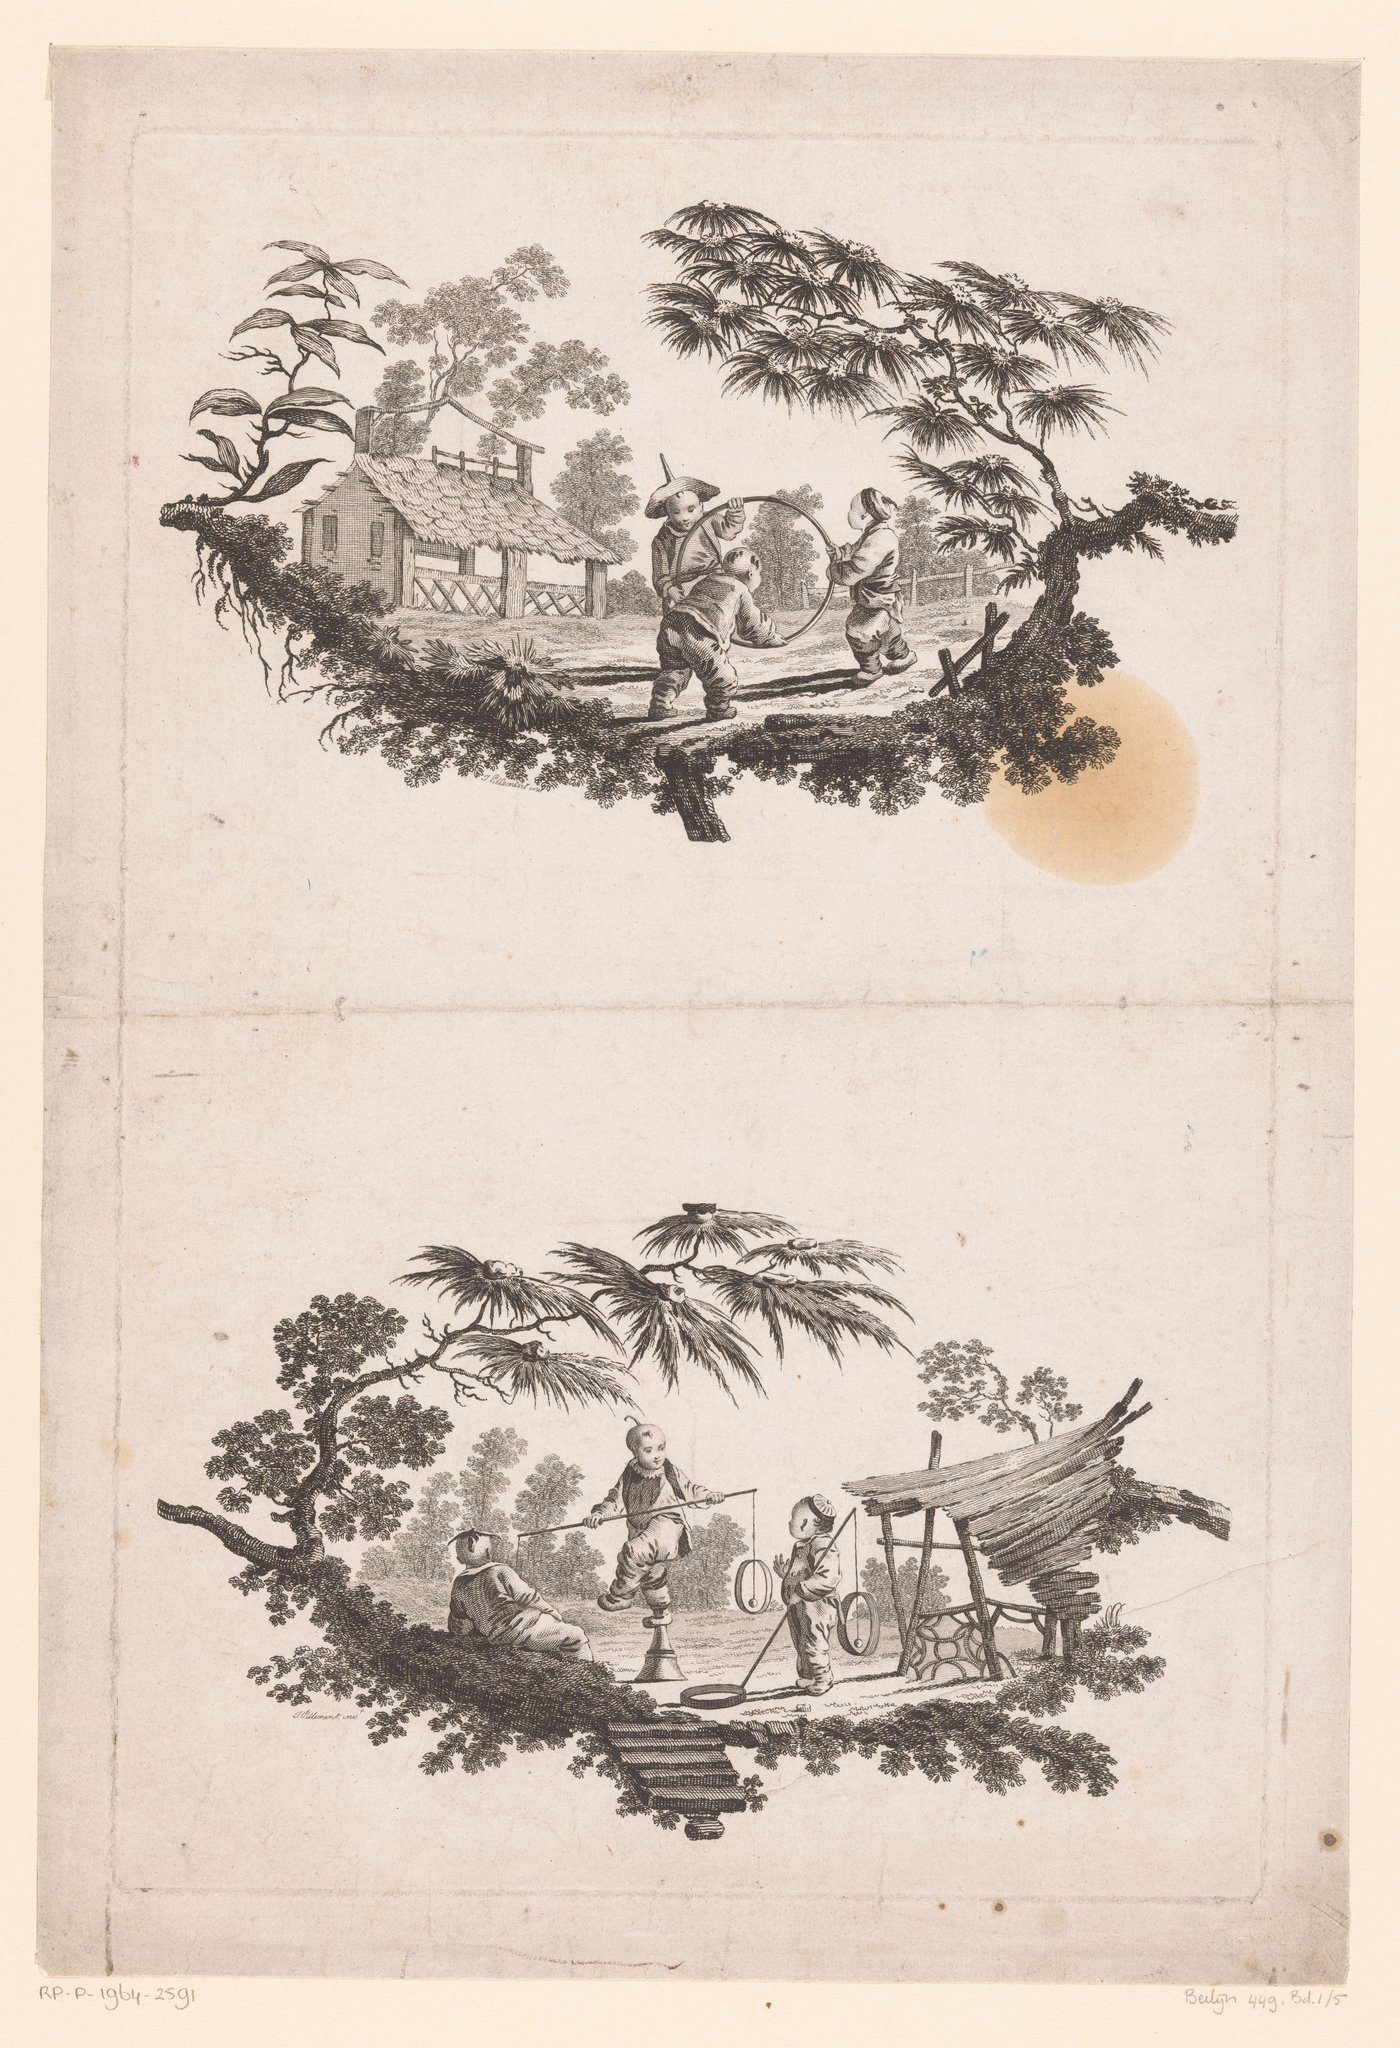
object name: print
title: Kinderen met hoepel en balancerend met stok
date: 1759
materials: paper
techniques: etching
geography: london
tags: children's games and plays, (bowling a) hoop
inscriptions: collector's mark: Lugt 2228, collector's mark: Lugt 2760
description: Boven: Drie Chinese kinderen spelen met een hoepel. Onder: Een Chinees kind balanceert op een pion met een stok in zijn handen. Twee kinderen kijken toe. Rondom beide voorstellingen een omlijsting met bomen en struiken.